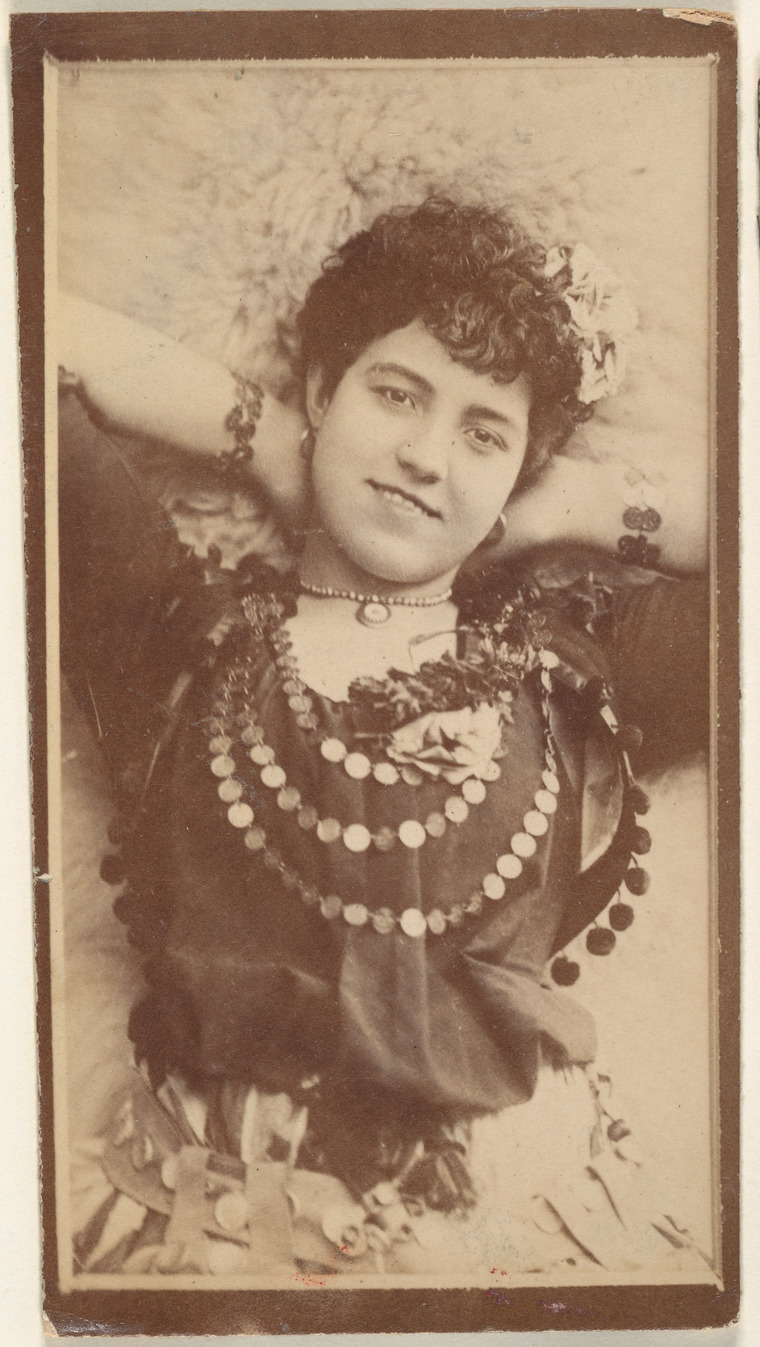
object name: photograph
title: Actress on back, viewed from above, from the Actresses series (N668)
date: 1888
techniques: albumen silver print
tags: portraits,women,actresses